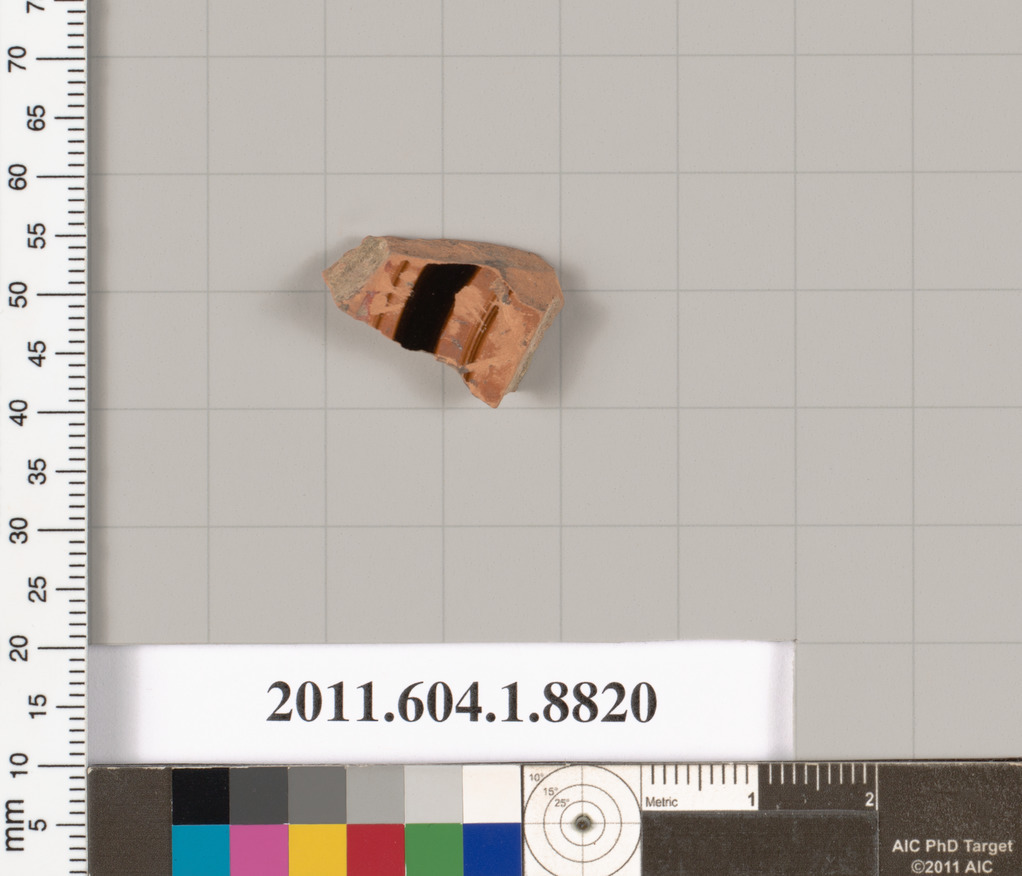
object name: kylix fragment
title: Terracotta fragment of a kylix (drinking cup)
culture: greek, attic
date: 600-401 BCE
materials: terracotta